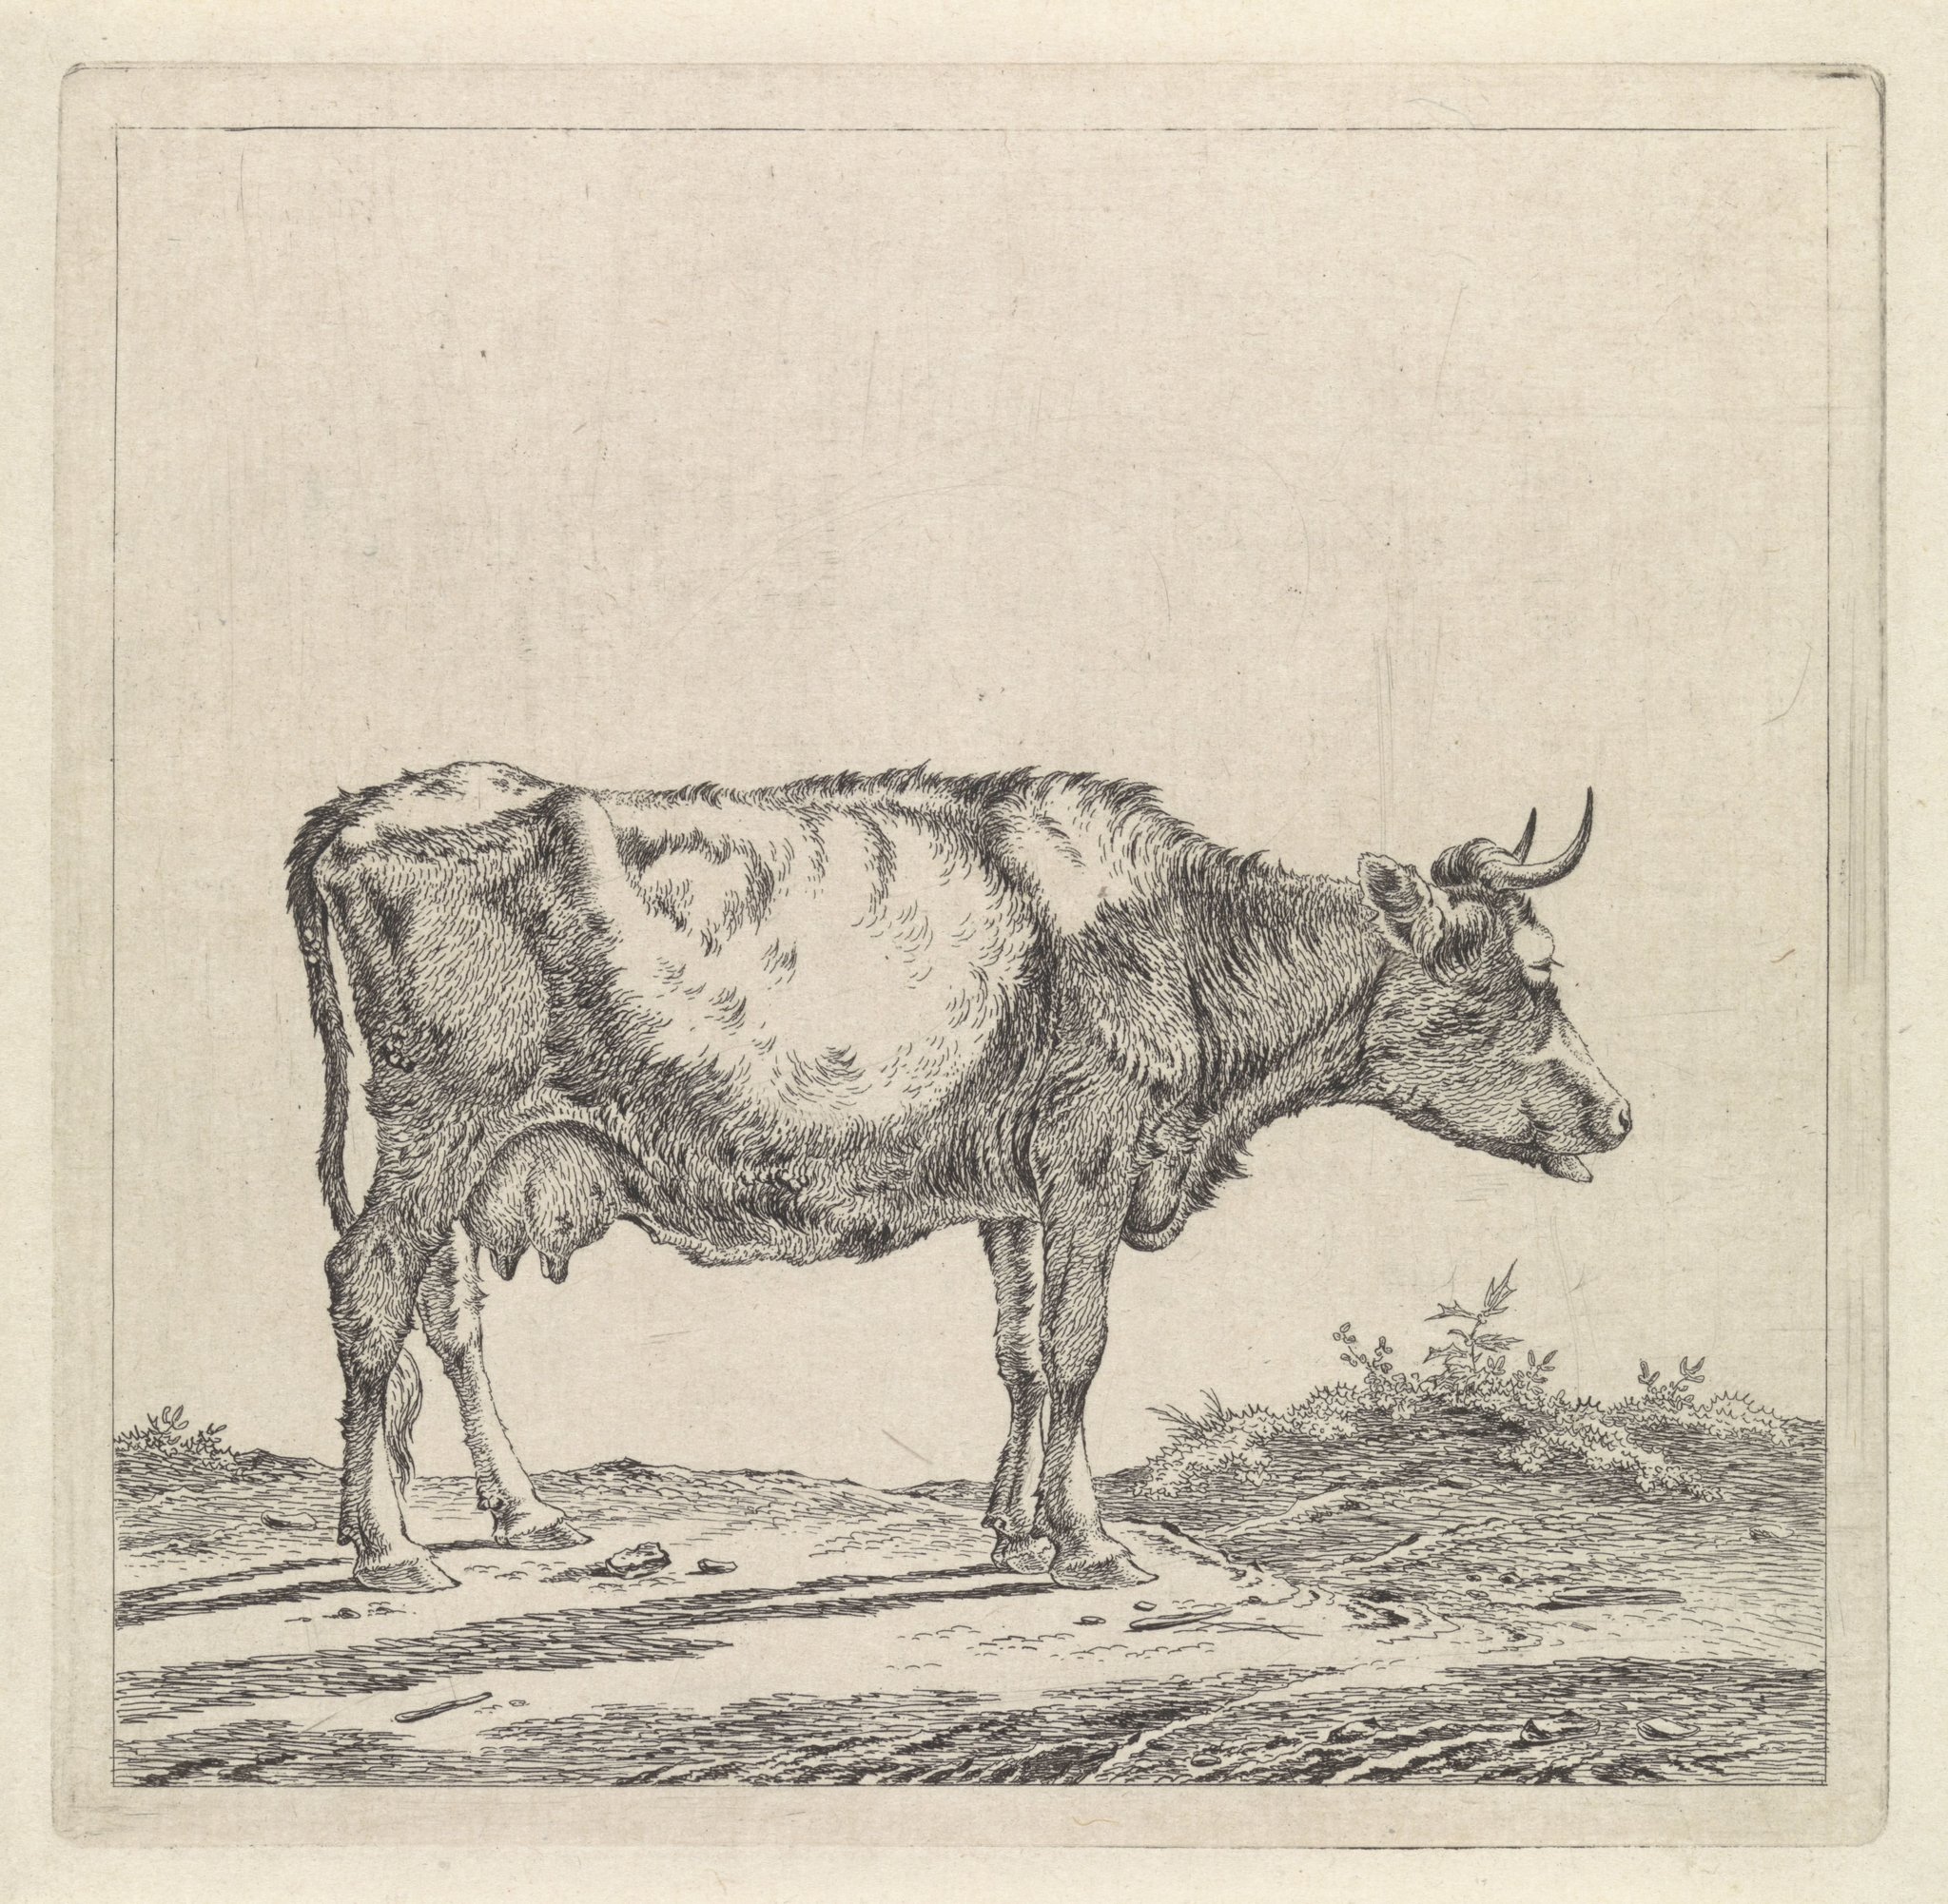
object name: print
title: Landschap met koe aan waterkant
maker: pieter janson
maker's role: draughtsman, print maker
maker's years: 1765-1851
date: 1780-1851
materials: paper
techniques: etching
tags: cow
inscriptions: collector's mark: Lugt 2228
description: Landschap met koe aan waterkant, naar rechts. Vóór de lucht en achtergrond.